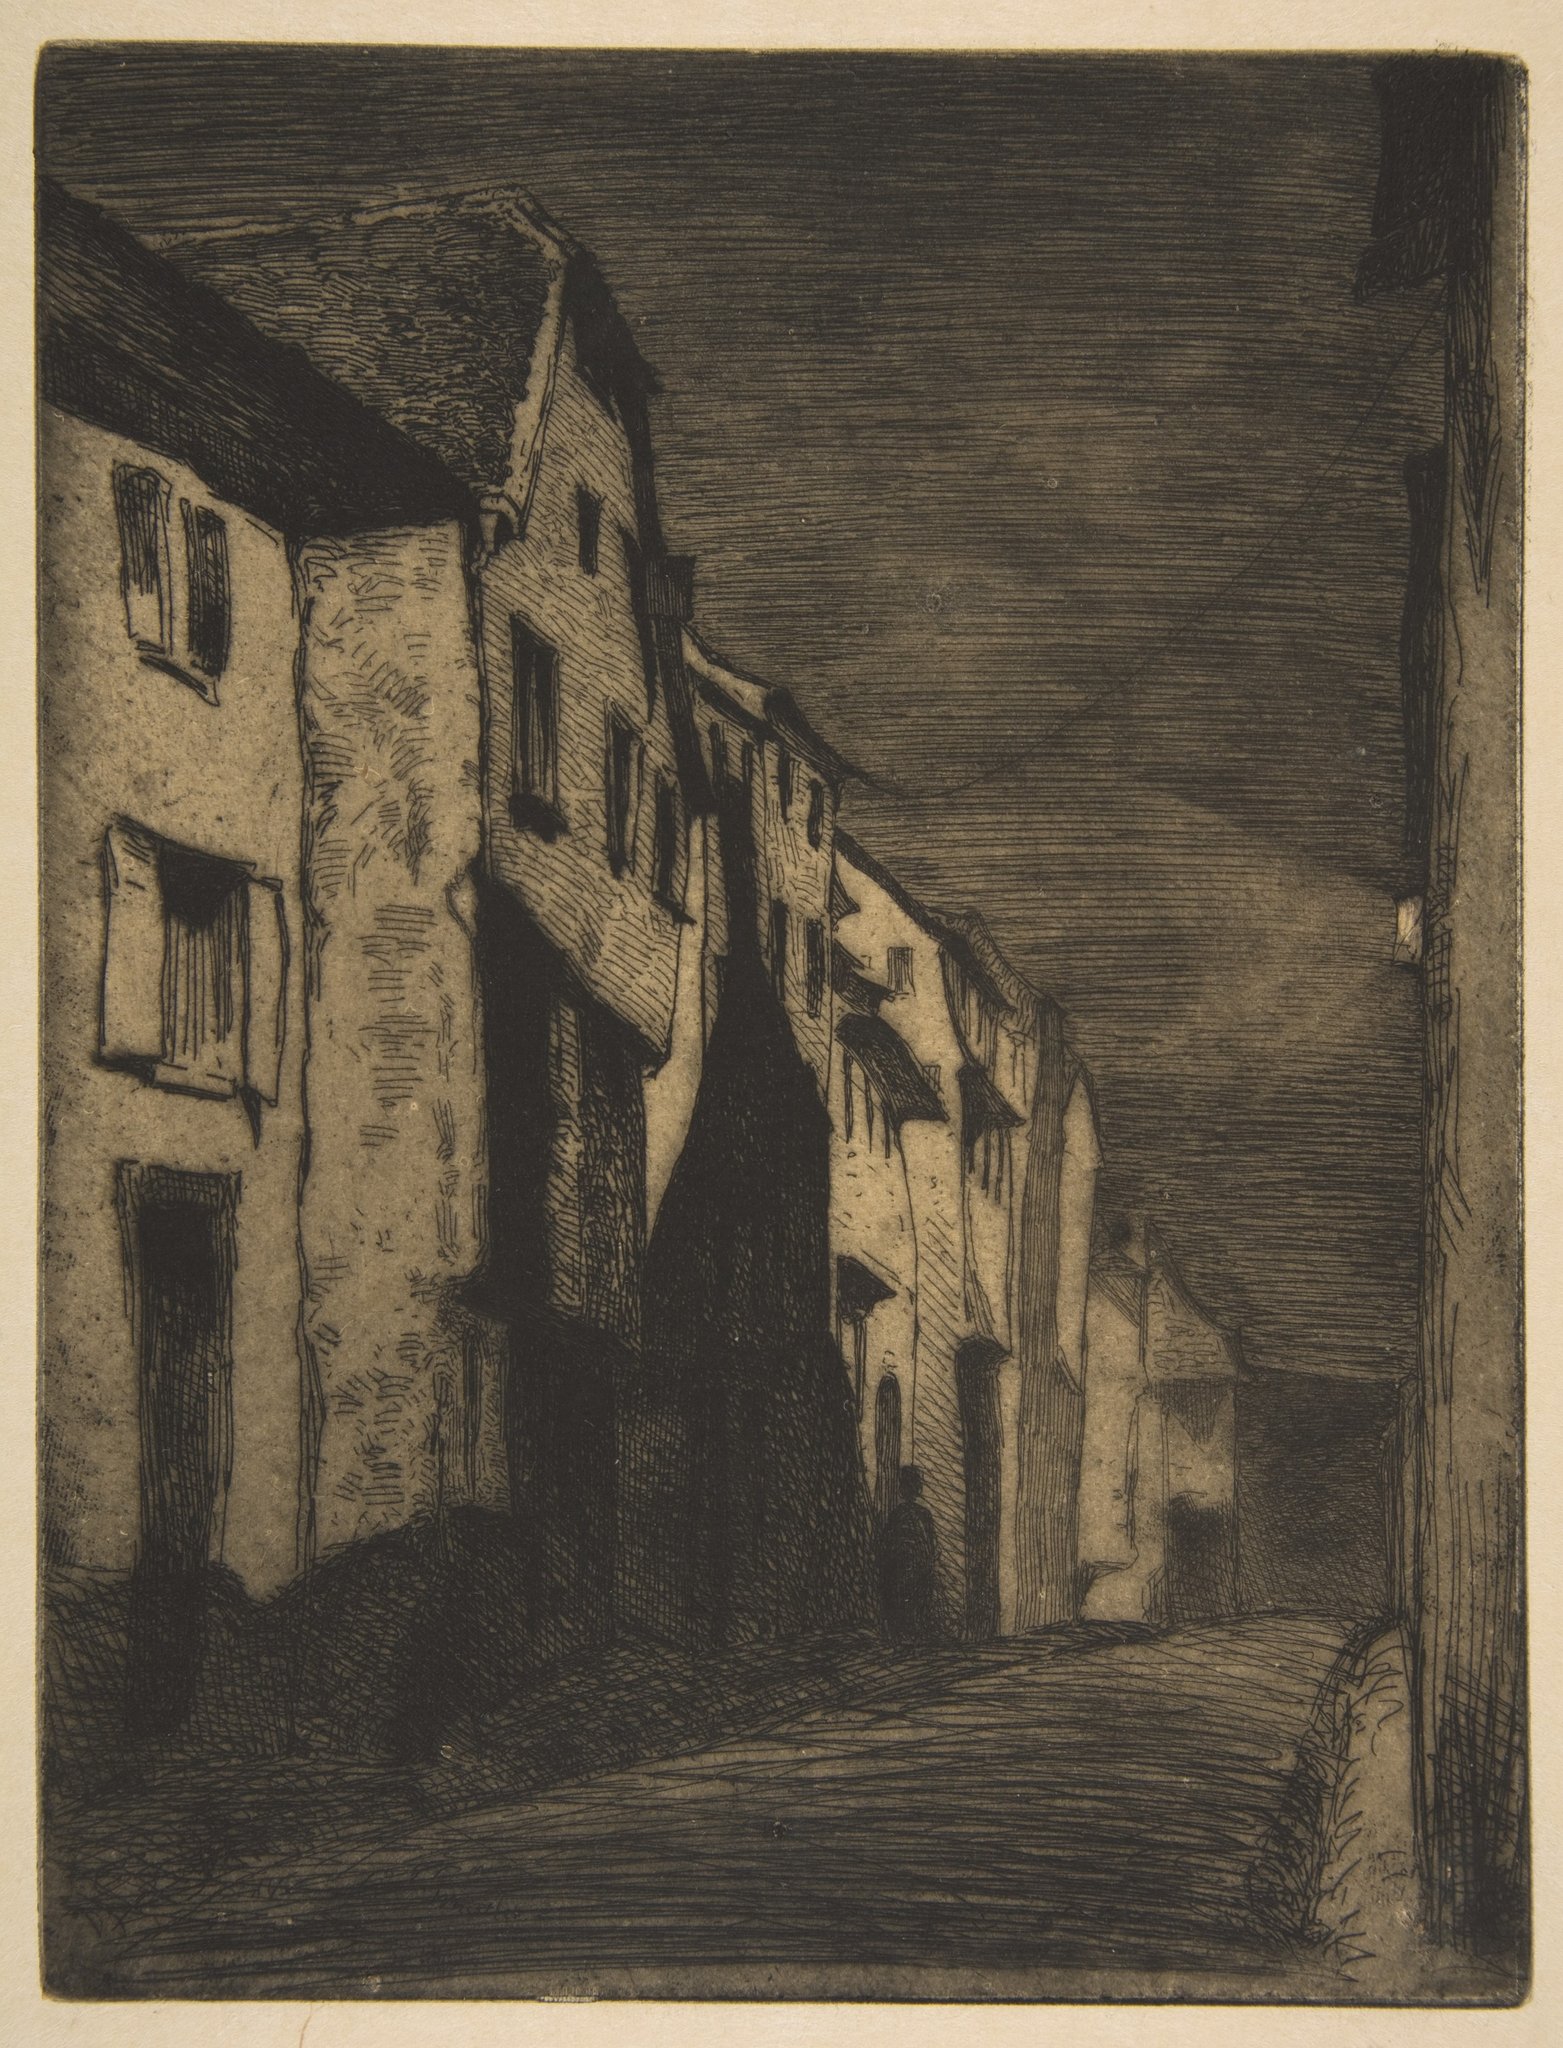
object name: print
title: Street at Saverne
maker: james mcneill whistler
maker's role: artist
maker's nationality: american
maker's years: 1834-1903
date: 1858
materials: ink, paper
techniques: etching, printing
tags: buildings,streets